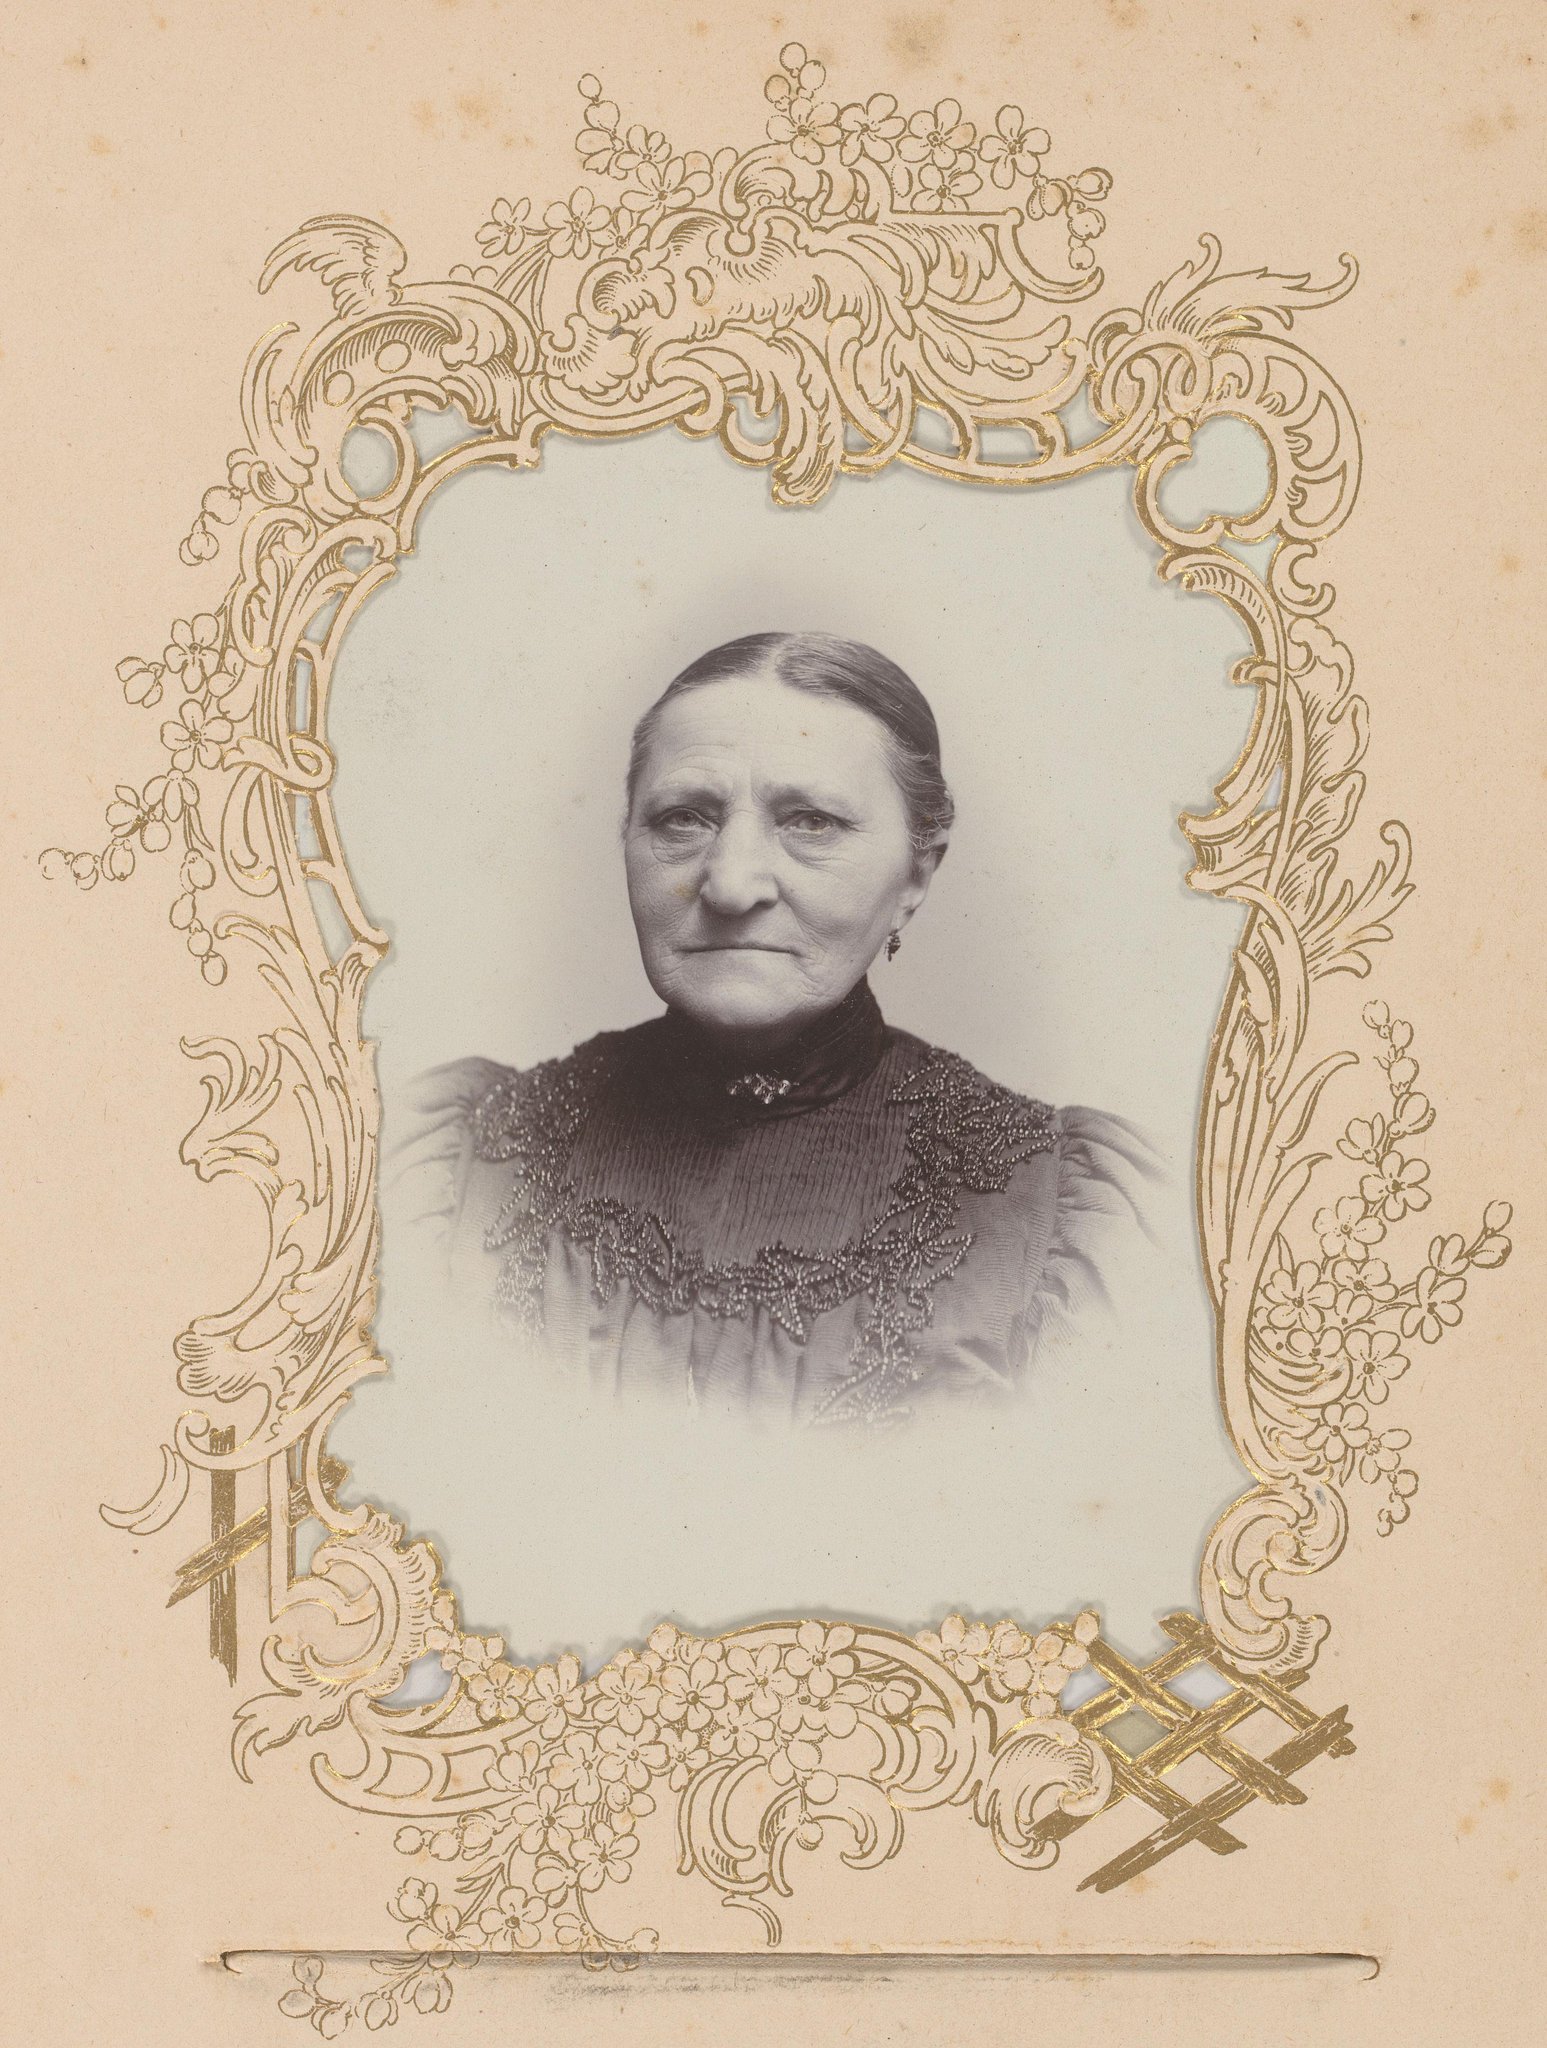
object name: photograph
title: Portret van een oude vrouw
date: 1885-1906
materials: cardboard, photographic support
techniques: collodion silver print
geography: amsterdam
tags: historical persons - bb - woman, old woman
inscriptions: inscription: ‘W.G. Kuijer & Zonen/ Amsterdam’